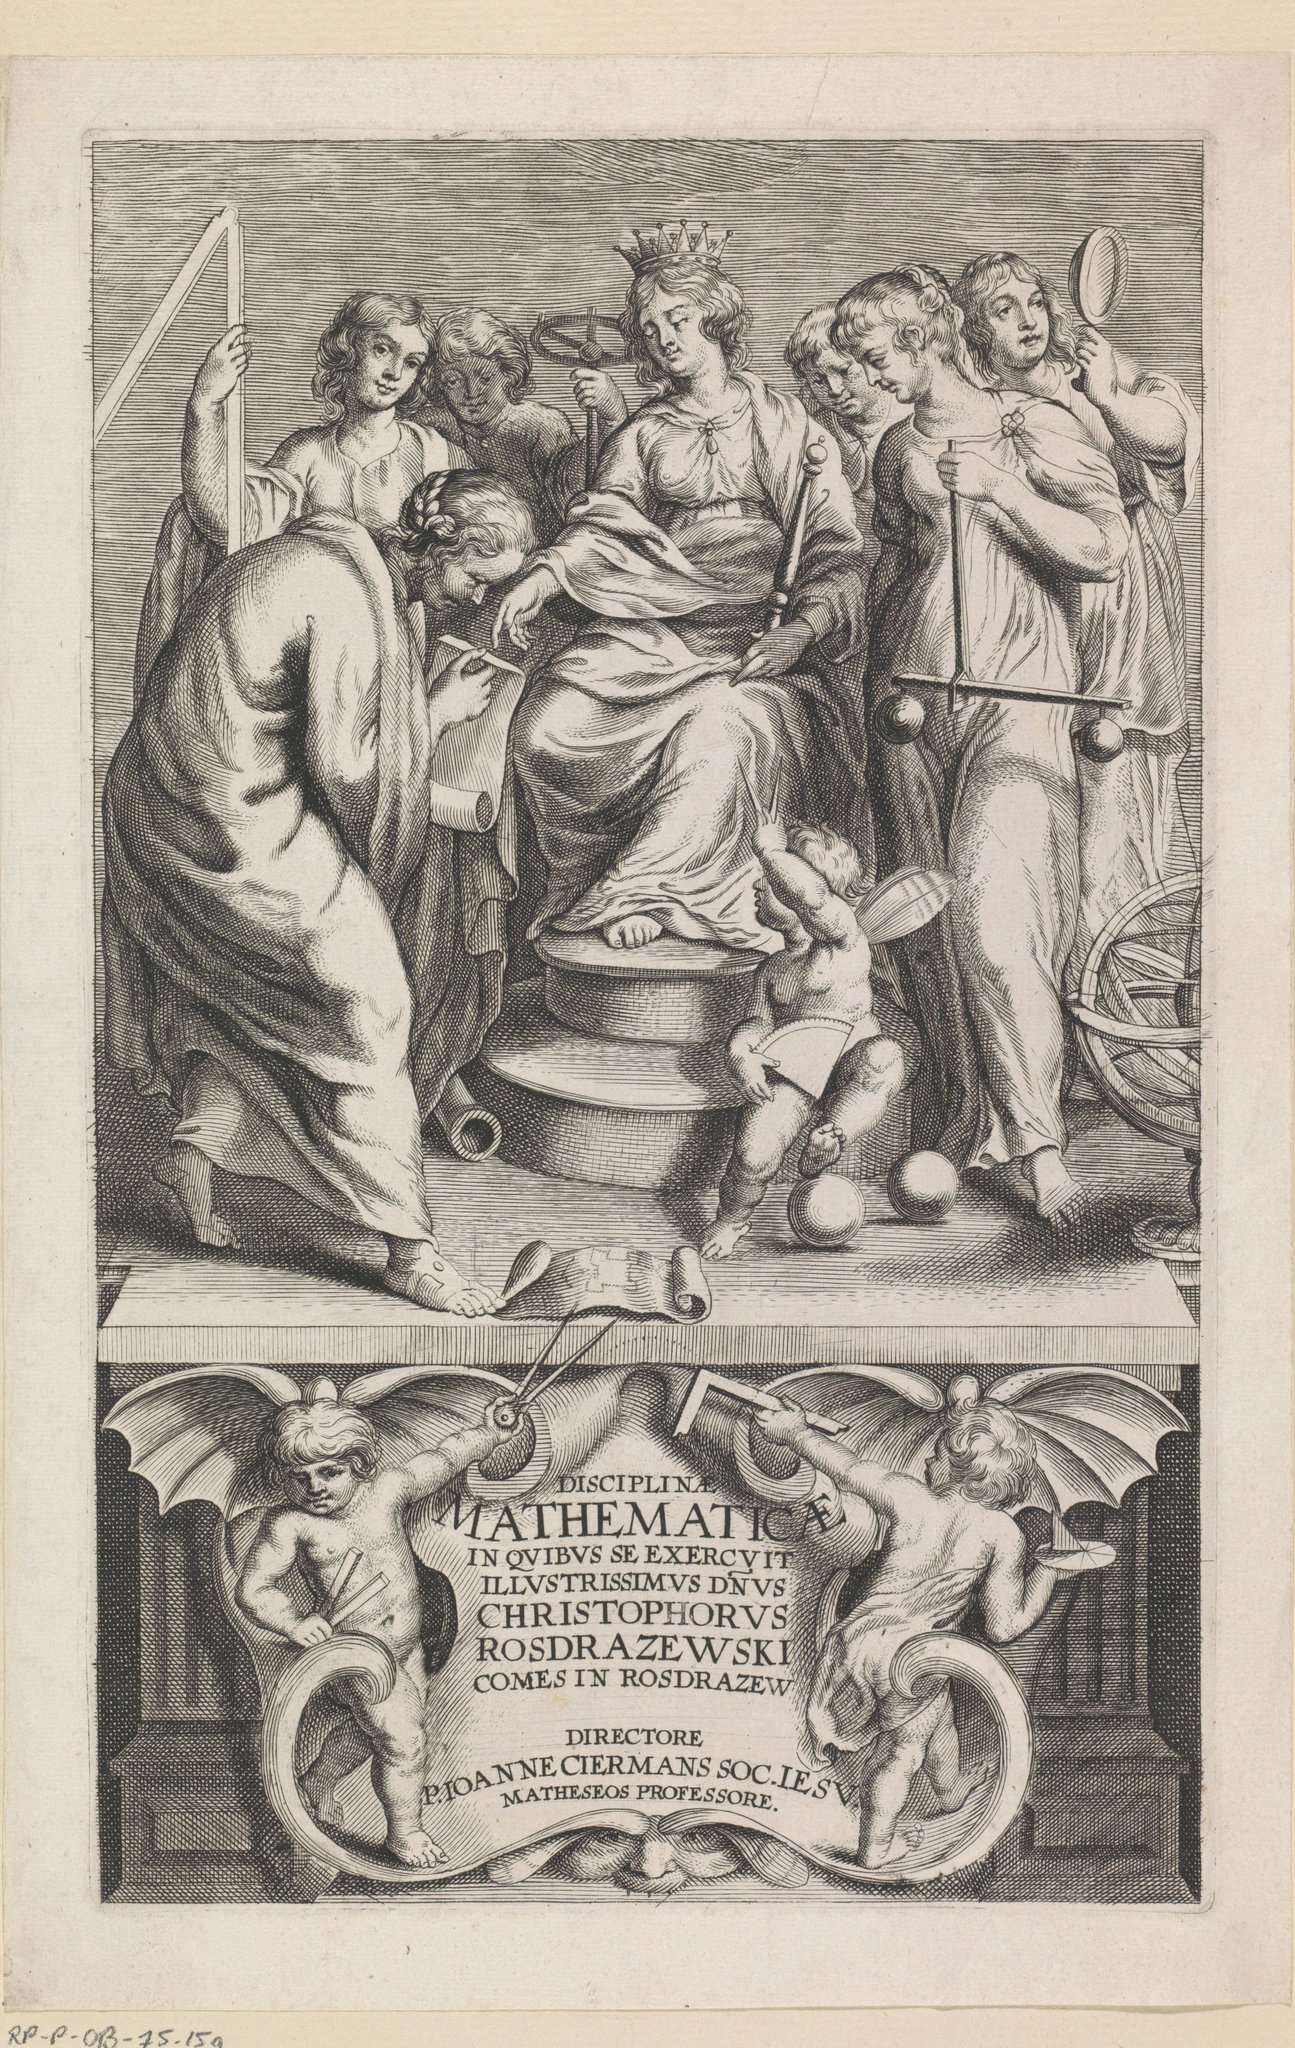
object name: titelblad, titelpagina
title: Titelpagina voor: Christophorus Rosdrazewski, Disciplinae Mathematicae, [1640-1648]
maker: Anonymous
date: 1640-1648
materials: paper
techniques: engraving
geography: southern netherlands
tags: 'mathematica'; 'mathematica' (ripa), prudence, 'prudentia'; 'prudenza' (ripa) ~ one of the four cardinal virtues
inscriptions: collector's mark: Lugt 240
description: De gekroonde personificatie van de Wiskunde zit op een verhoging en houdt een scepter in haar hand. Rondom haar staan andere personificaties, onder anderen Meetkunde met passer en Wijsheid met spiegel. Onderaan een cartouche met de titel geflankeerd door twee putti. Titelpagina voor een wiskundig proefschrift.